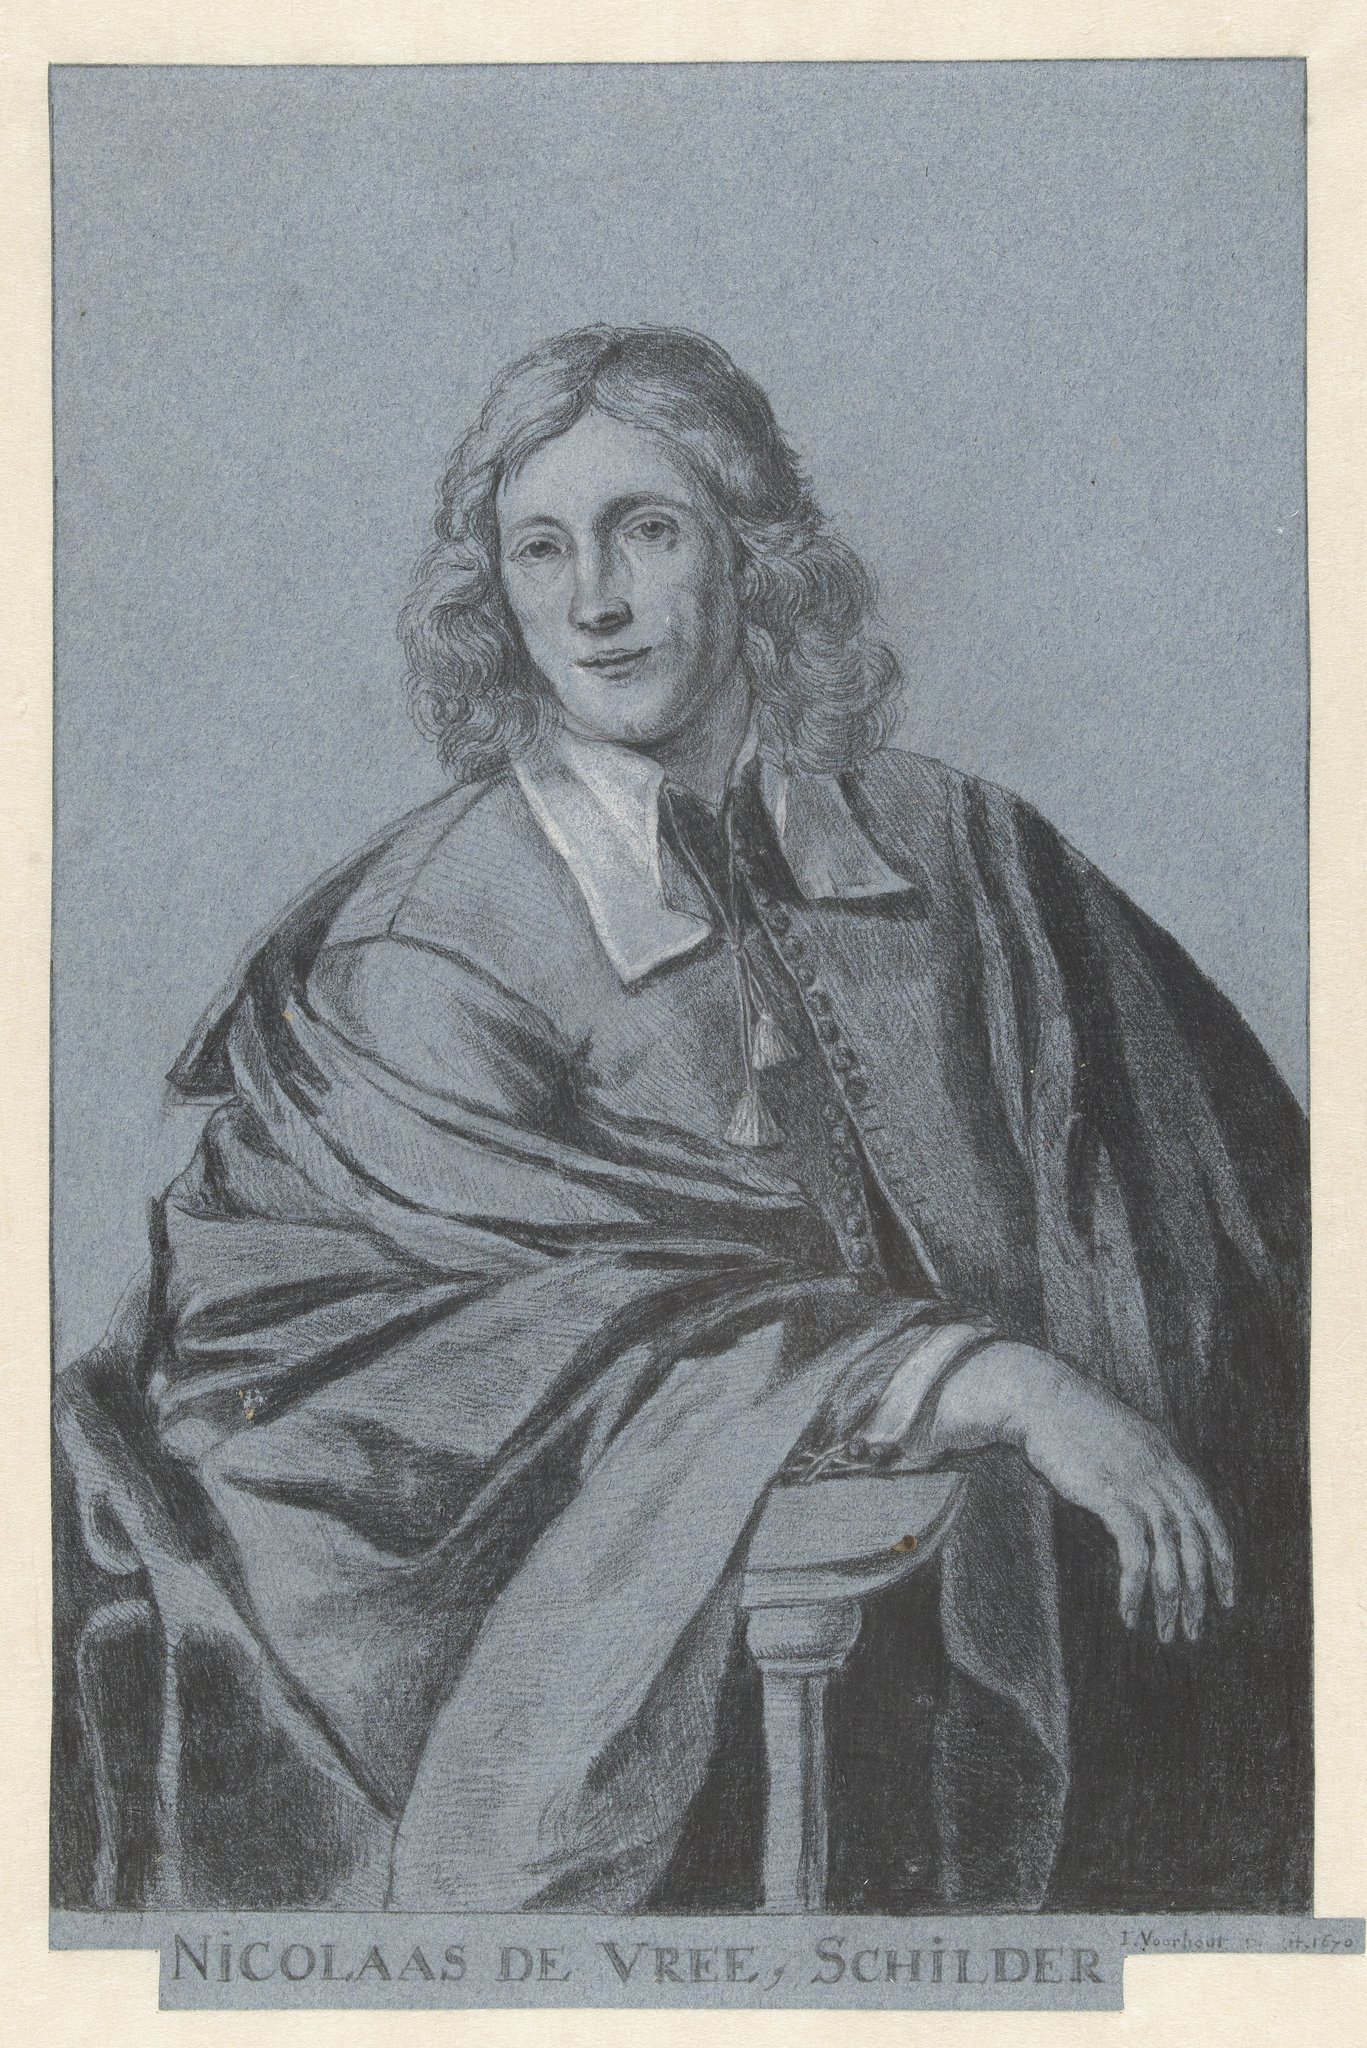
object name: drawing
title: Portret van de schilder Nicolaes de Vree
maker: johannes voorhout (i)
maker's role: draughtsman, painter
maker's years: 1647-1723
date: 1670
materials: chalk, paper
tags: historical persons, portrait, self-portrait of painter, portrait, self-portrait of artist